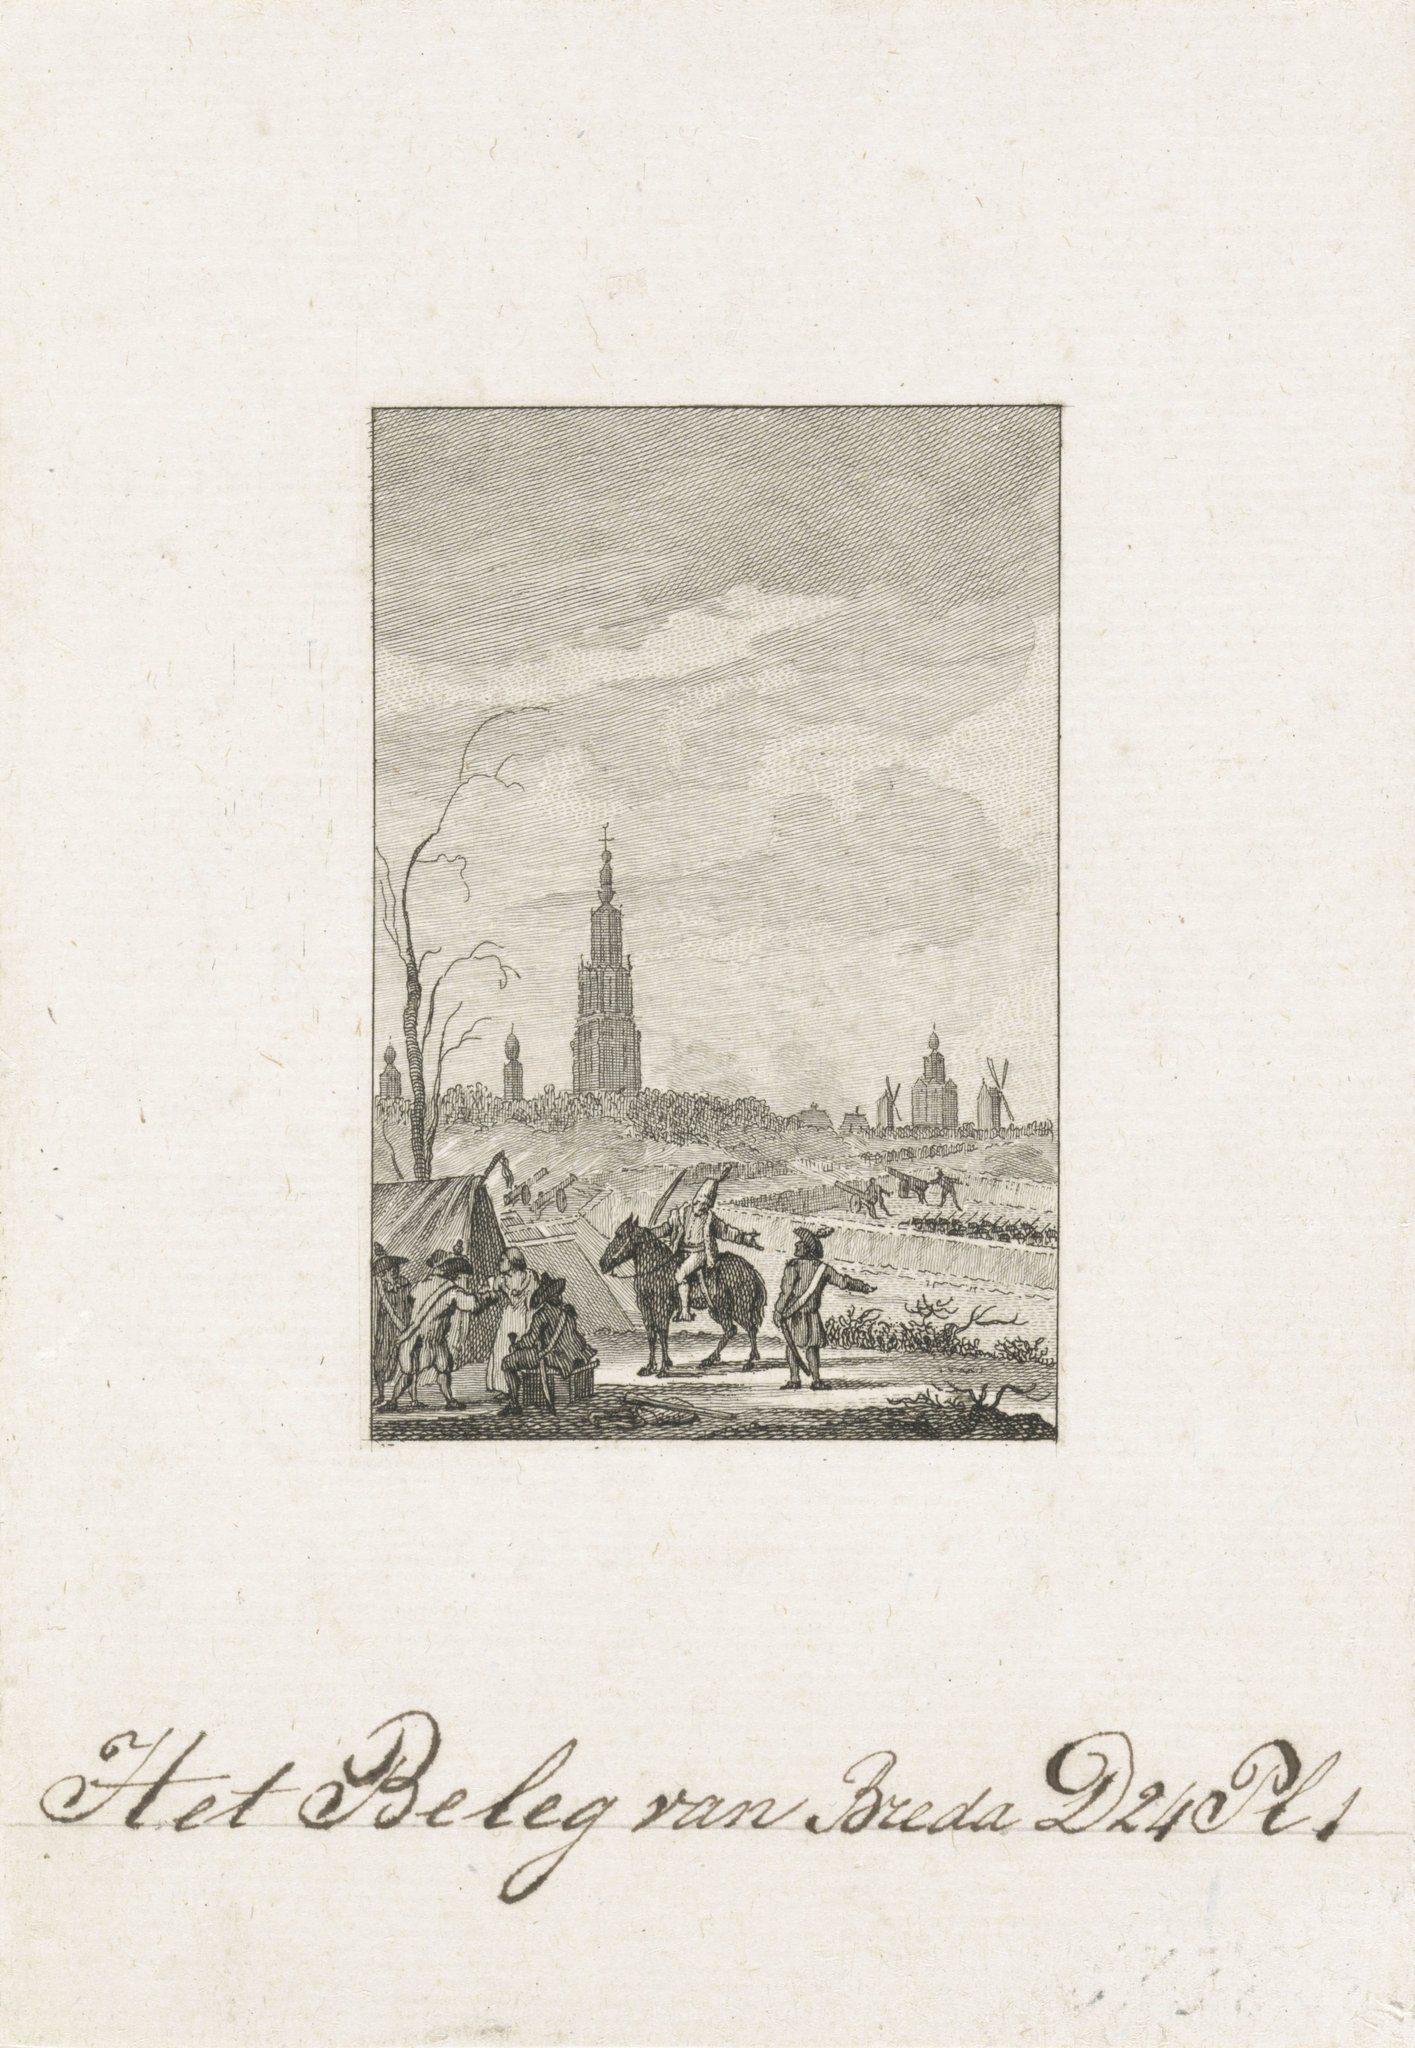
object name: print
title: Beleg van Breda, 1793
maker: cornelis bogerts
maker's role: print maker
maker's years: 1745-1817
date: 1793-1795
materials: paper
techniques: engraving, etching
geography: northern netherlands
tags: siege, position war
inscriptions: collector's mark: Lugt 2228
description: Gebruikt als illustratie in: J. Fokke, Geschiedenissen der Vereenigde Nederlanden voor de vaderlandsche jeugd, Johannes Allart, Amsterdam 1783-1795, 25 delen, dl. 24, pl. 1.